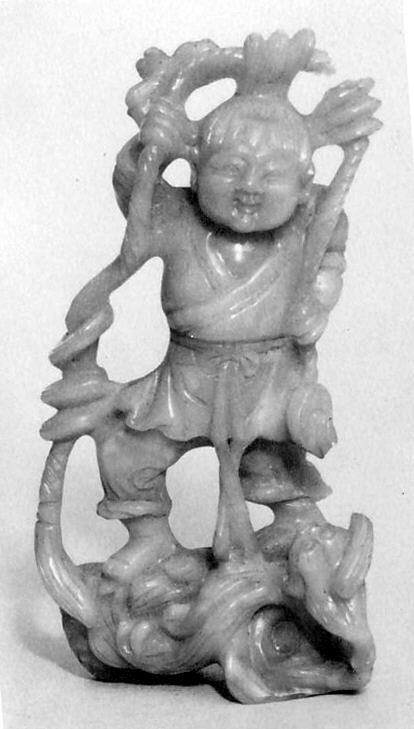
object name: figure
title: Figure of a Boy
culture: japanese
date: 1801-1900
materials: amber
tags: boys